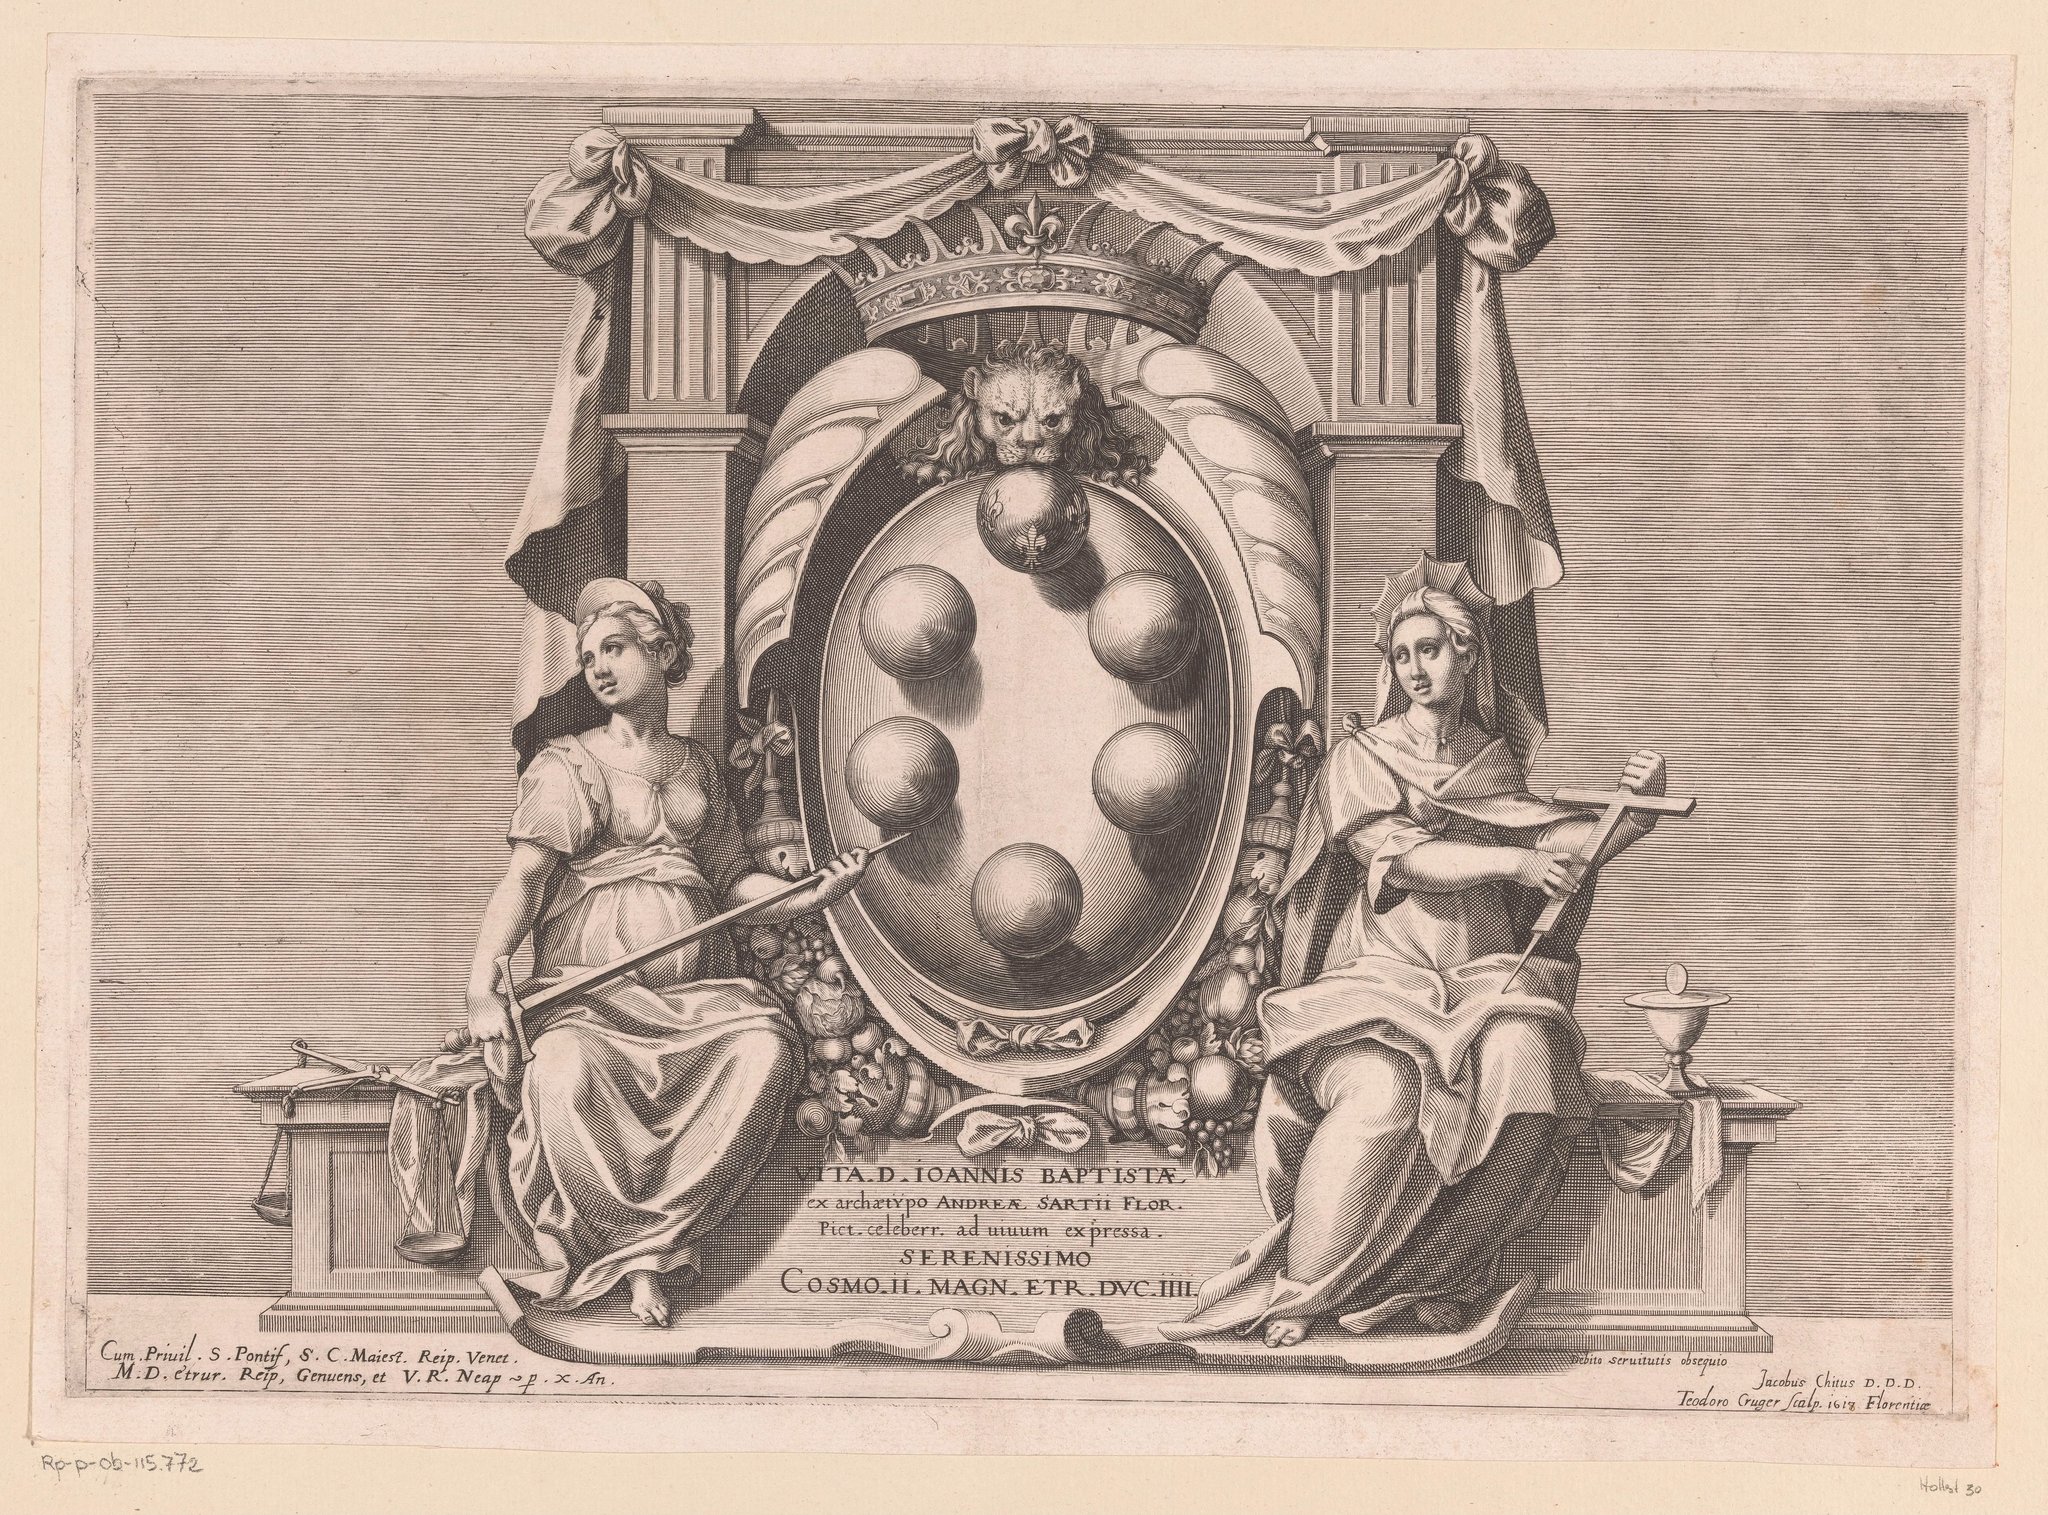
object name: titelprent, frontispice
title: Scènes uit het leven van Johannes de Doper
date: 1617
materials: paper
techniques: engraving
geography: venice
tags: fides (faith) as roman personification, justitia (justice) as roman personification, armorial bearing, heraldry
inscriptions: collector's mark: Lugt 240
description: Onderdeel van een serie van dertien prenten en een titelprent. Het jaartal is met inkt veranderd naar 1618.